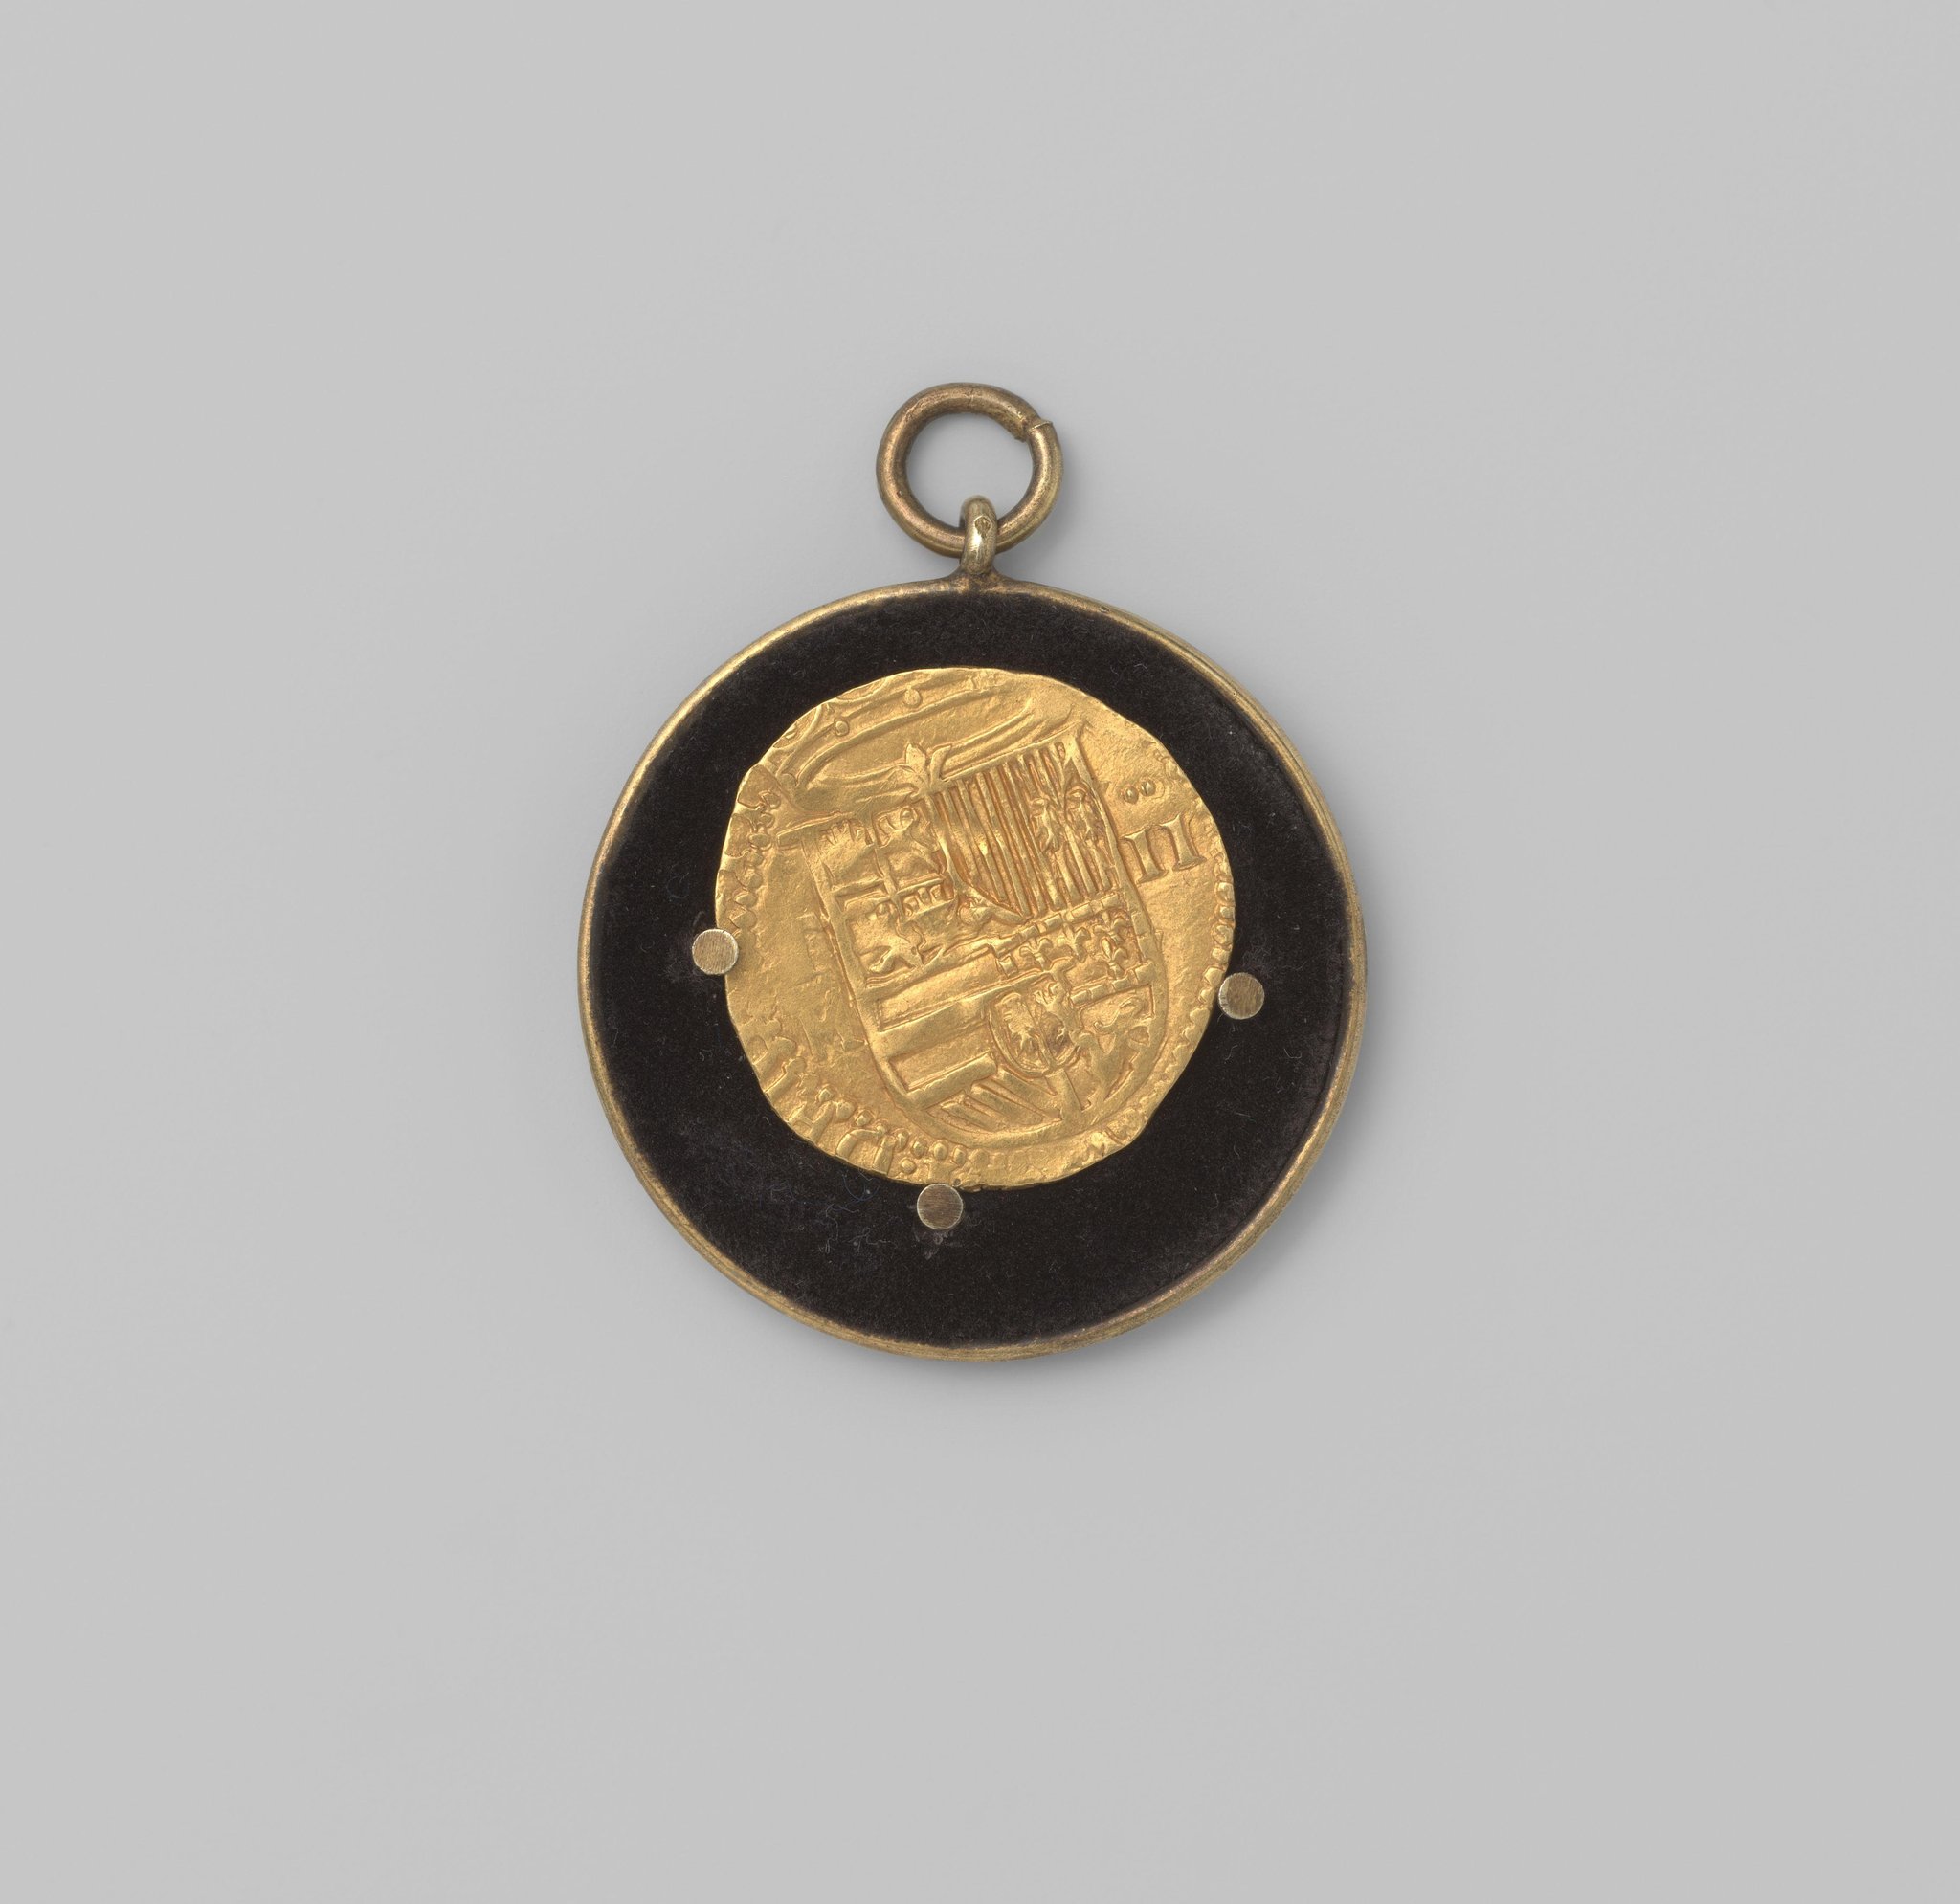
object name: dubbele escudo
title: Gouden dubbele escudo Philips II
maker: Anonymous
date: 1600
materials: gold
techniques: striking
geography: europe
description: Gouden handelsmunt afkomstig uit Nederlandse muntvondst.